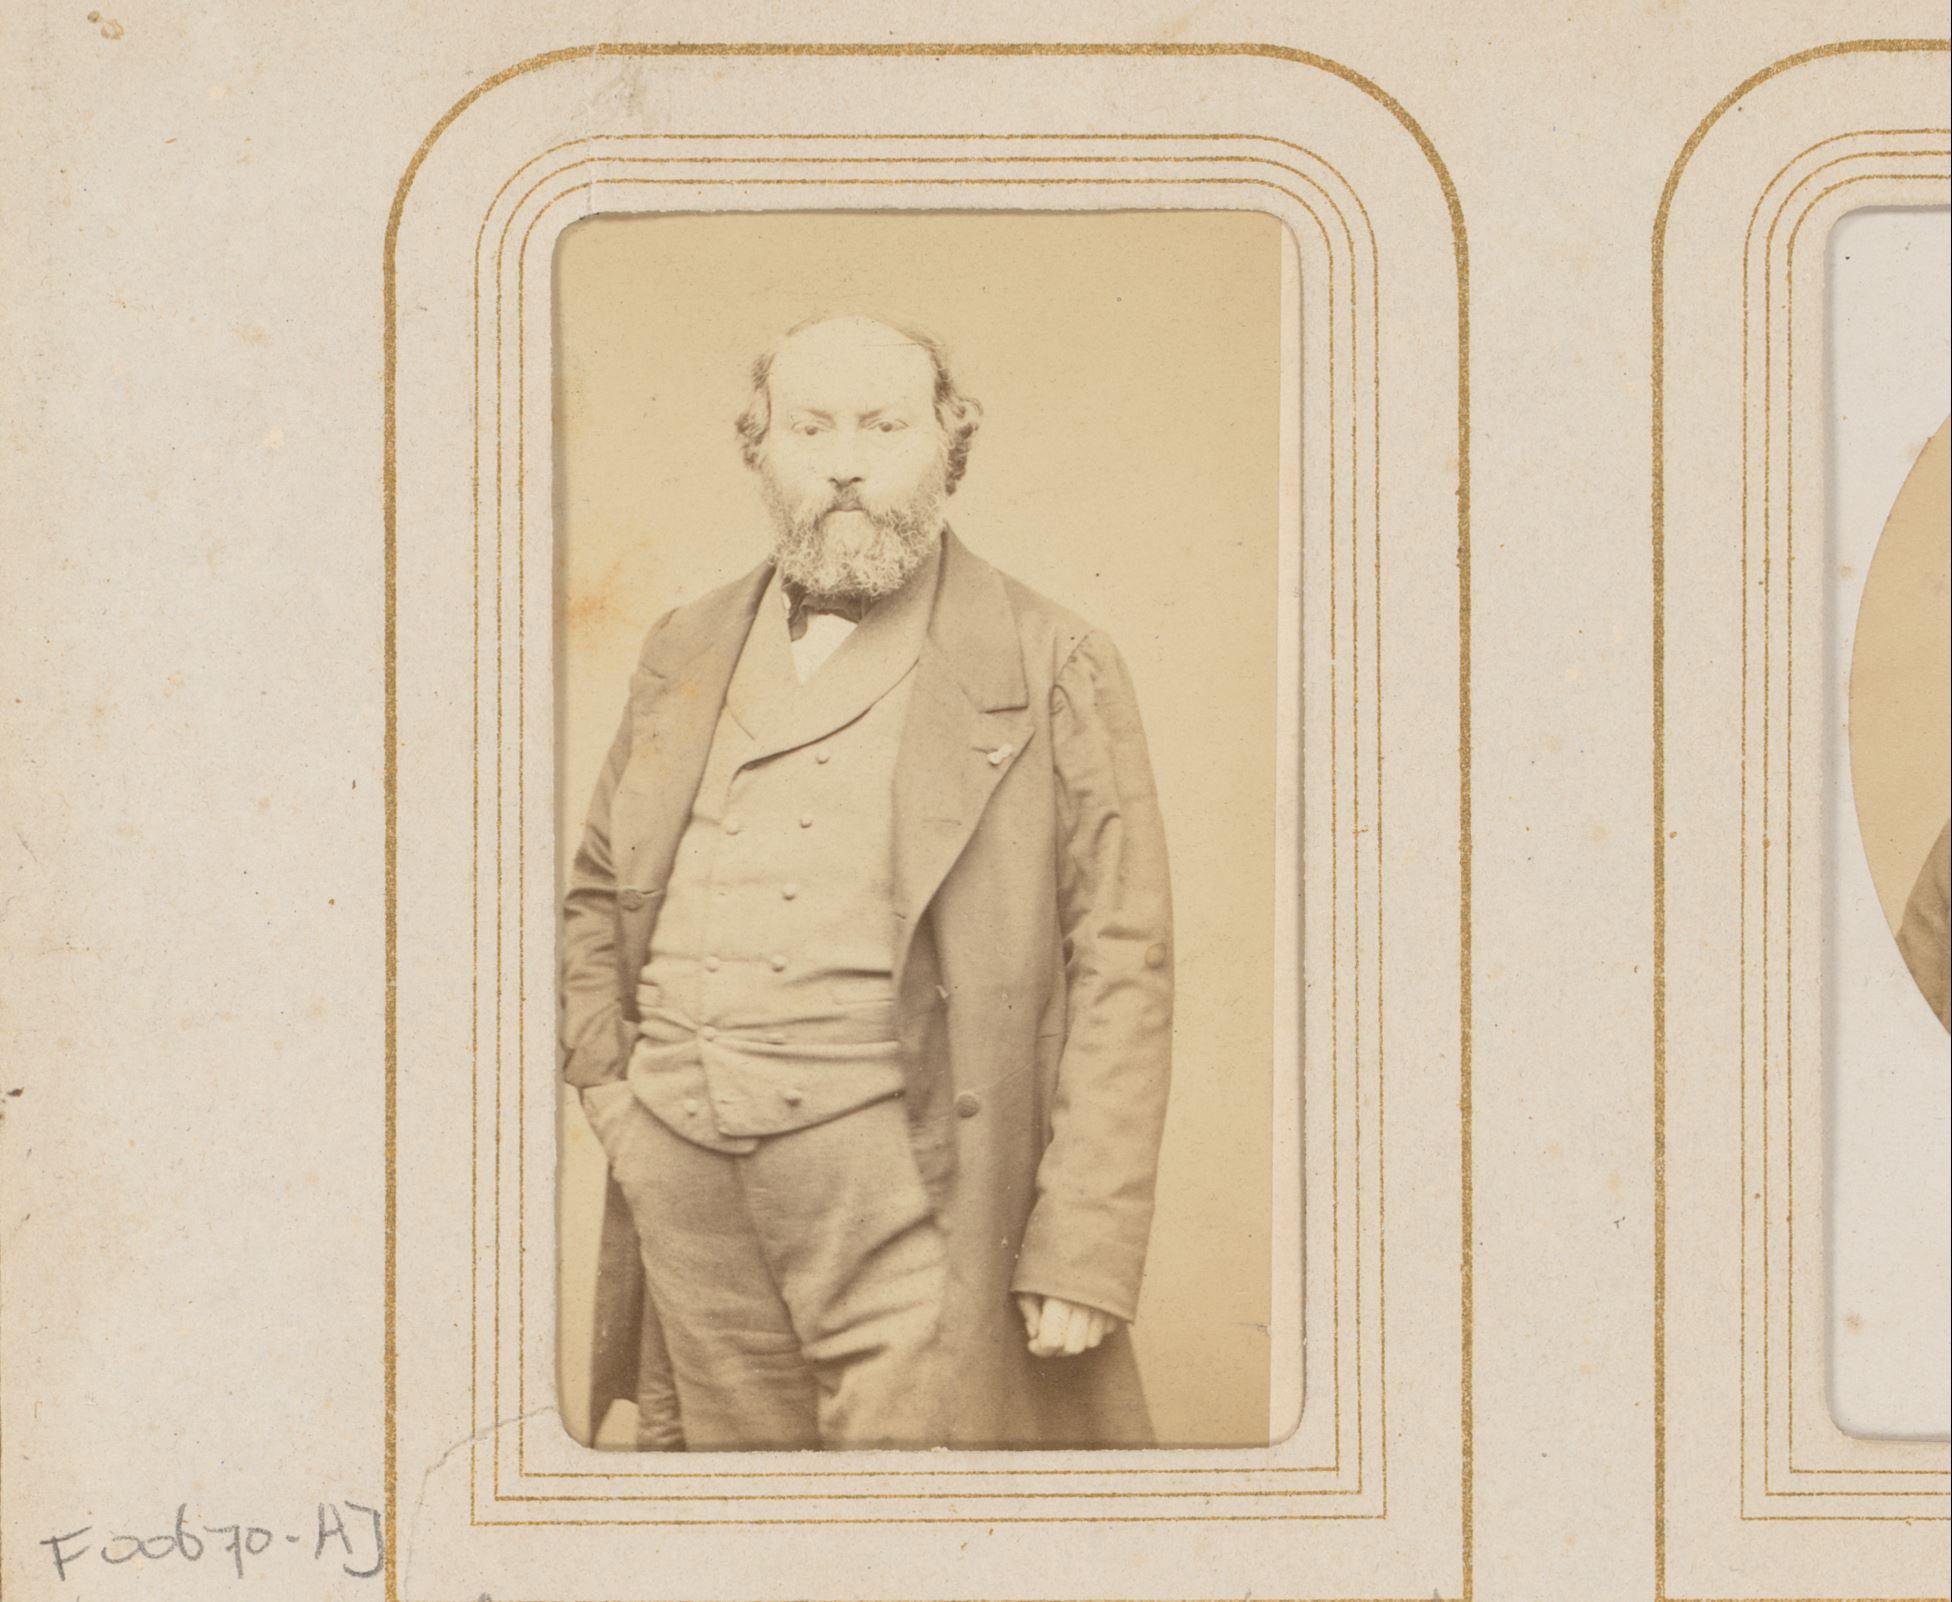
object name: album leaf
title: Portret van Theodore Rousseau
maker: étienne carjat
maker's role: draughtsman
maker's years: 1828-1906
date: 1861-1867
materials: cardboard, photographic support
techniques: albumen print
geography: paris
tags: paris, print maker, draughtsman, théodore rousseau, historical persons, portrait, self-portrait of painter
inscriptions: inscription: ‘Photographie/ Carjat & Cie/ 56, Rue Laffitte’, annotation: ‘Theodore Rousseau fr. schilder/ 1812-1867 (Carjat)’